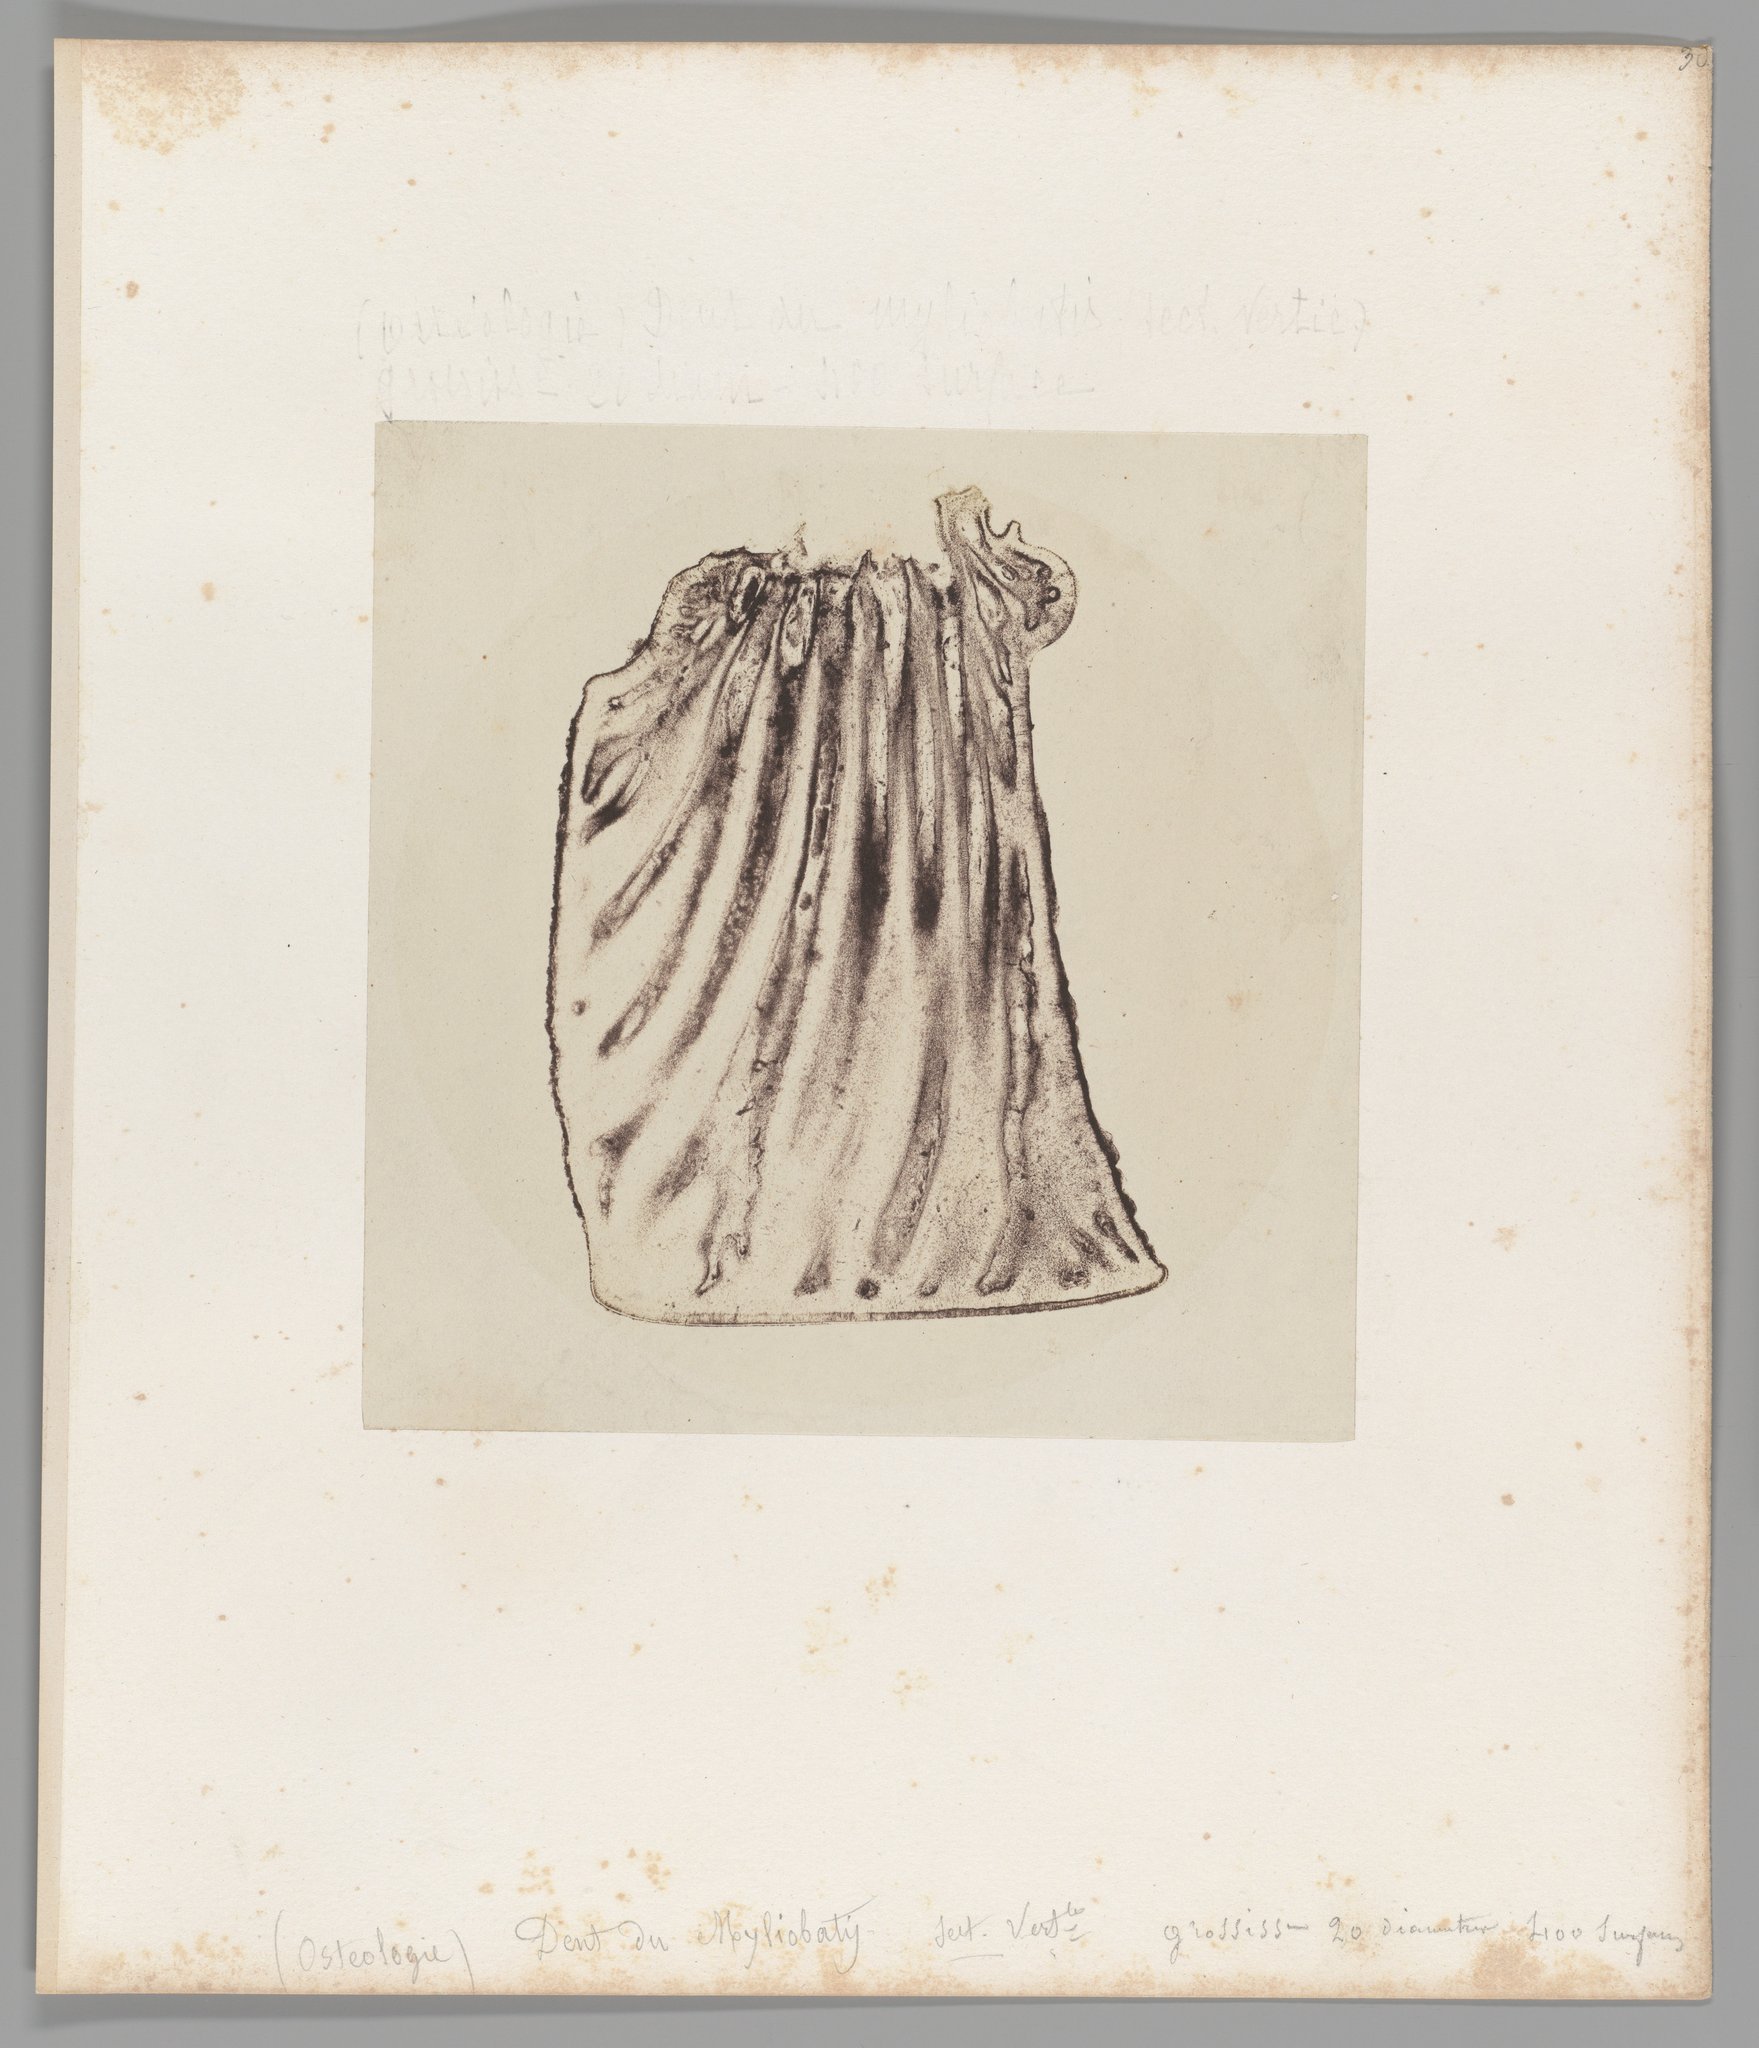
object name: photograph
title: [Untitled]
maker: auguste-adolphe bertsch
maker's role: artist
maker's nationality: french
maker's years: 1813-1871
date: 1853-1857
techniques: salted paper print